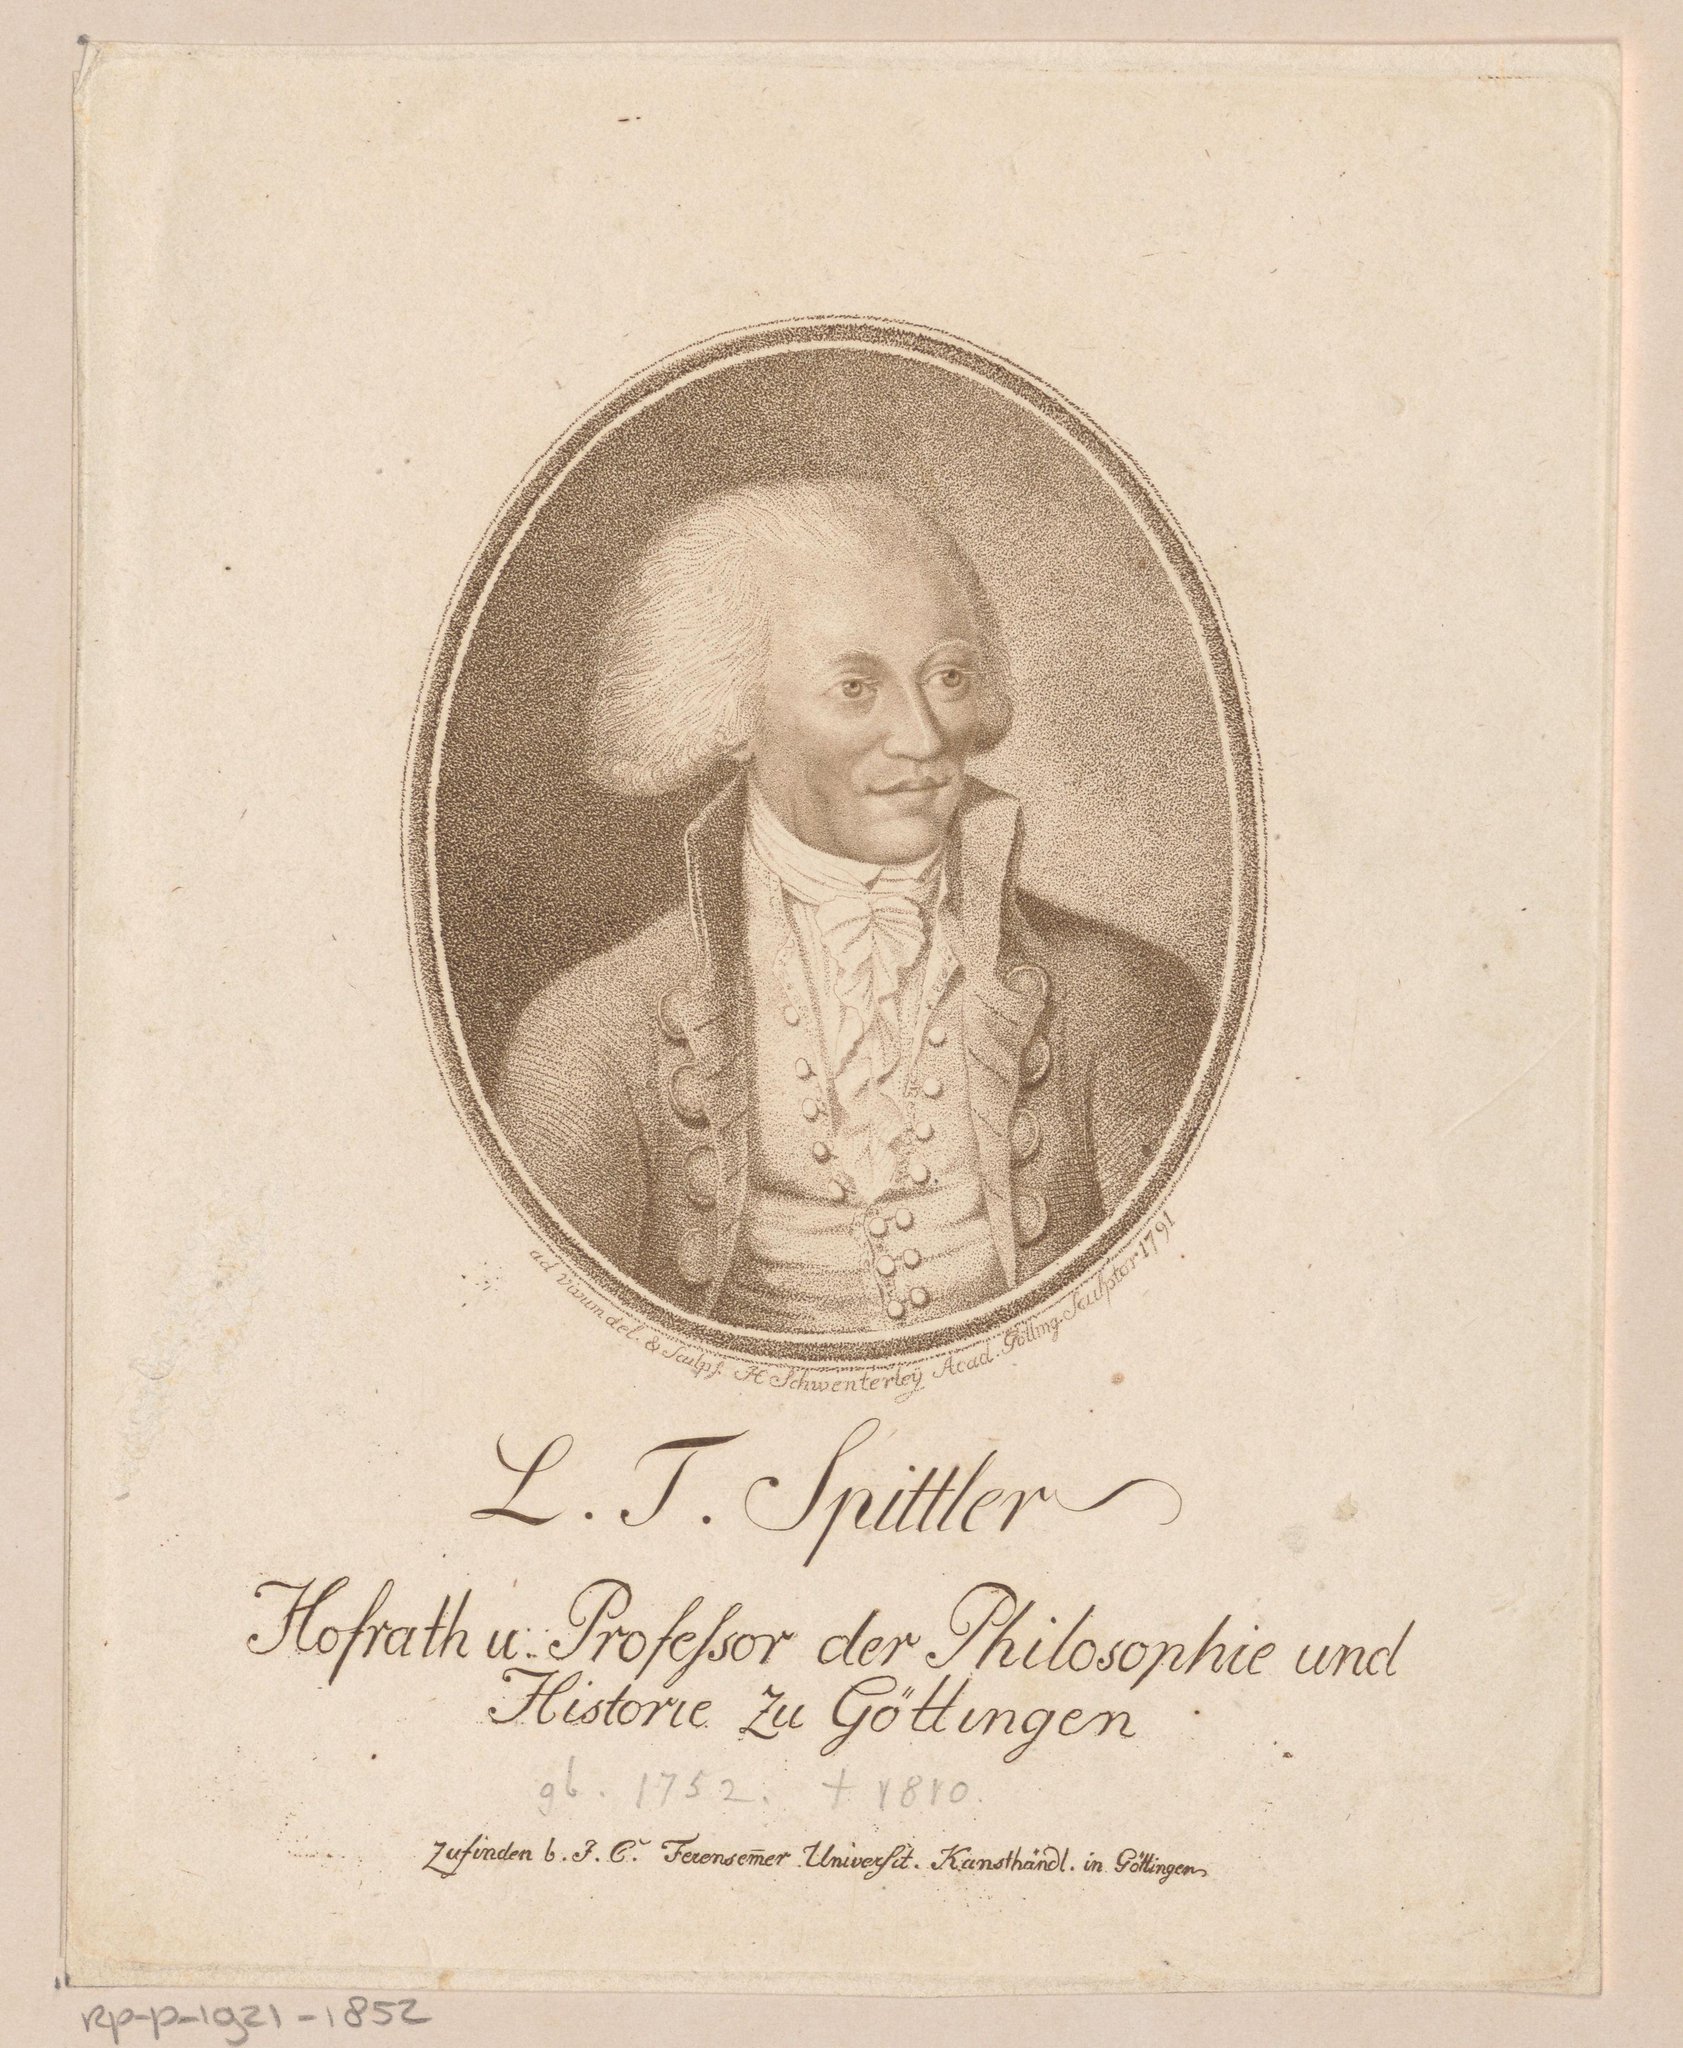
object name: print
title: Portret van Ludwig Timotheus Spittler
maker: heinrich schwenterley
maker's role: print maker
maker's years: 1749-1815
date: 1791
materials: paper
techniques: etching, roulette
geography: gottingen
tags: history and archaeology (+ portrait of scholar, scientist), historical persons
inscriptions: collector's mark: Lugt 2233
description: Met tweeregelig onderschrift in het Duits.